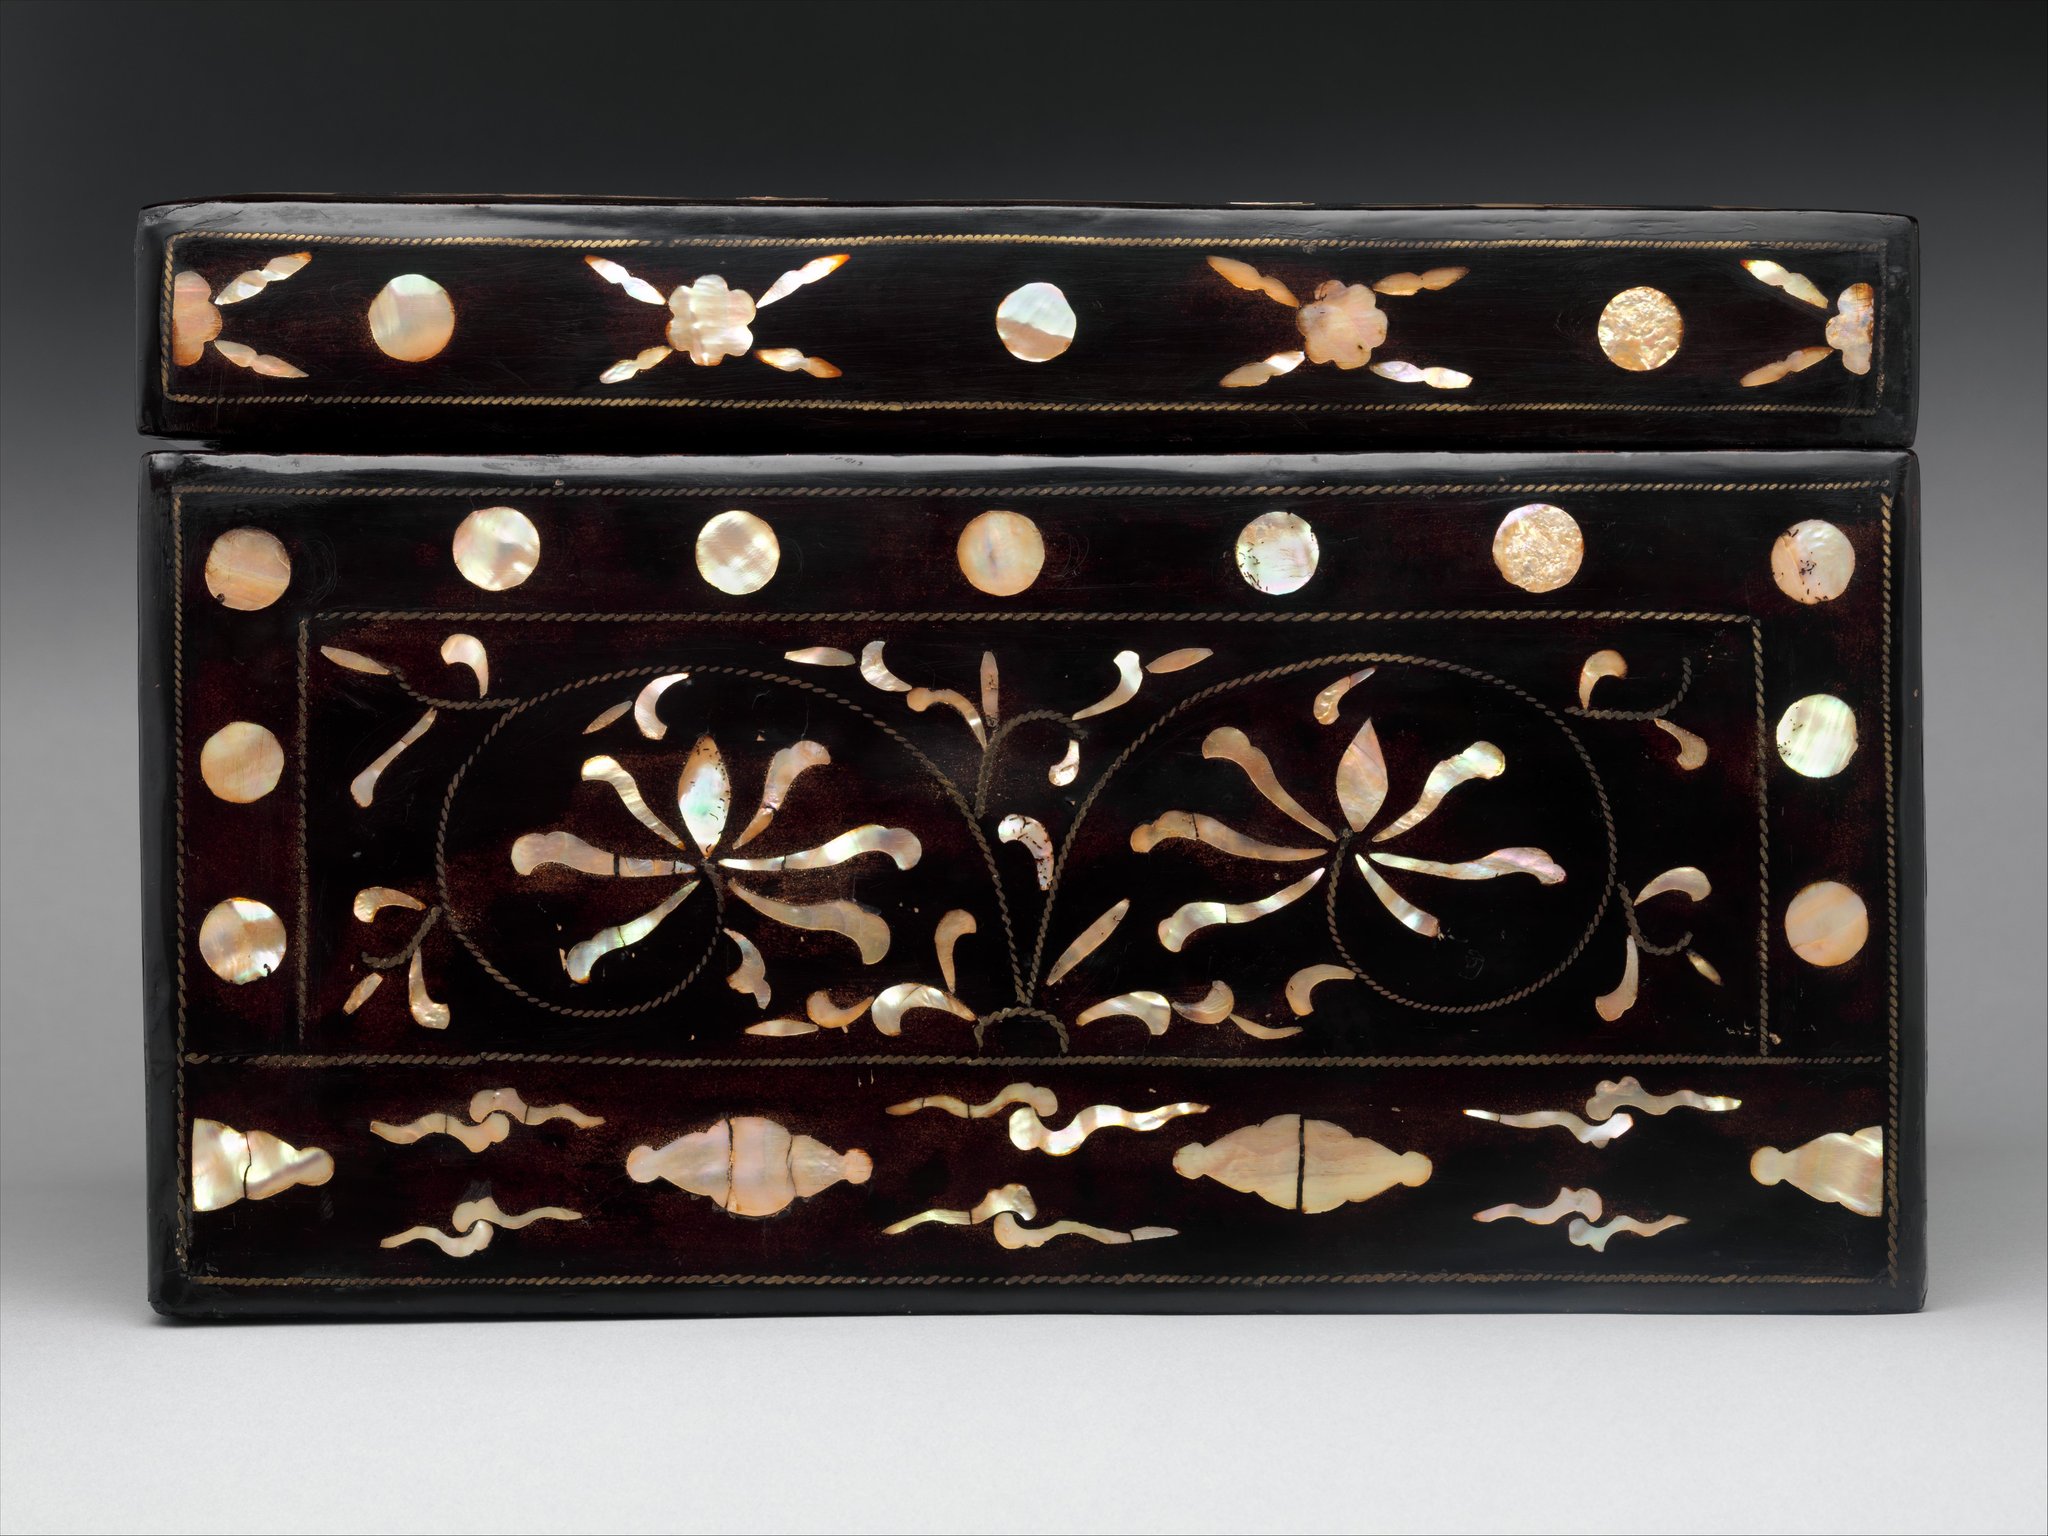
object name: box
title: Box decorated with flowers and clouds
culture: korean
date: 1701-1800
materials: brass, lacquer, mother of pearl, shell, metal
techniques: inlay